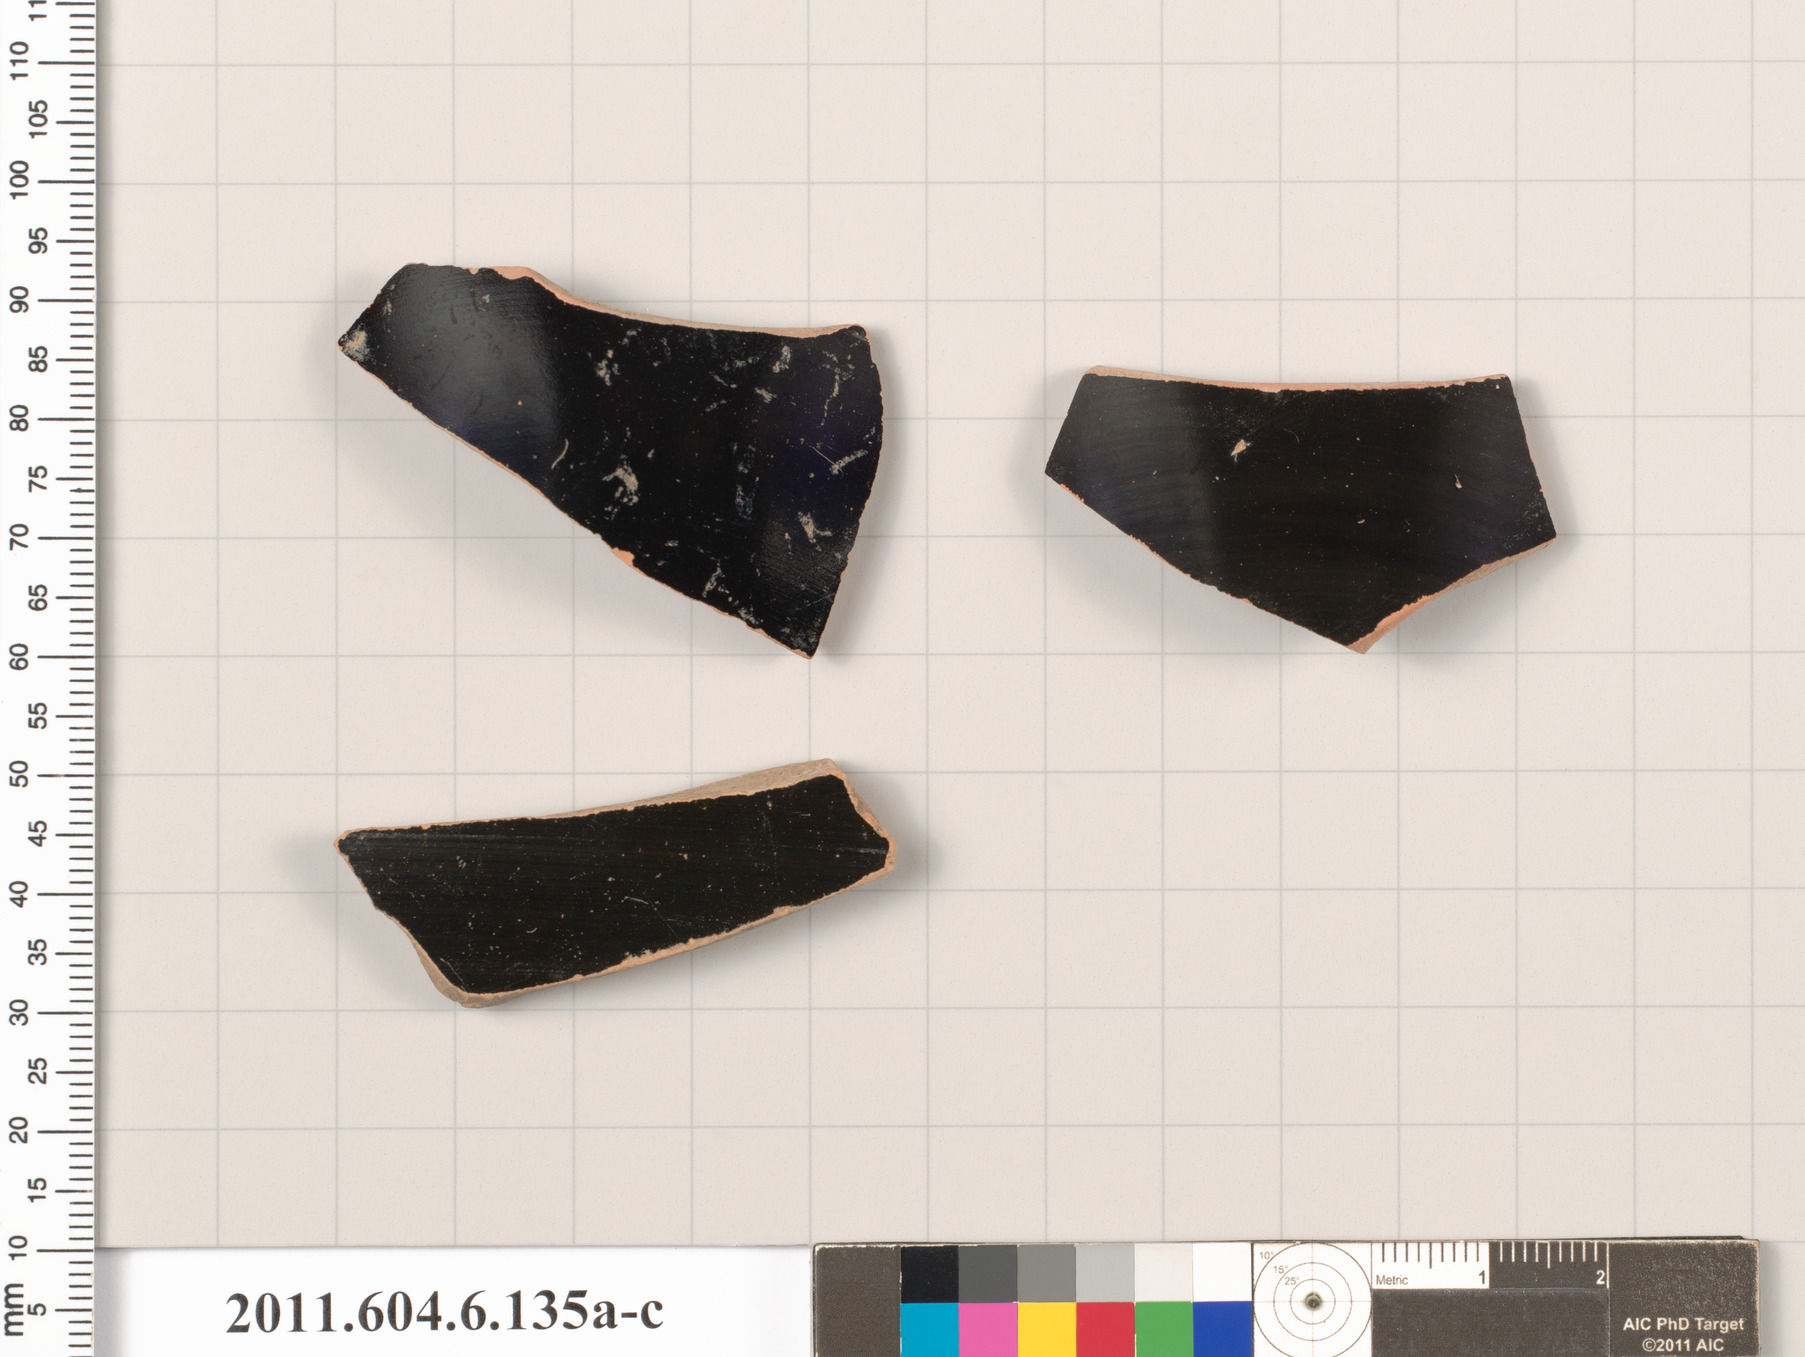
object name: undetermined open shape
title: Terracotta fragments of open shapes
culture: greek, attic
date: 600-401 BCE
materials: terracotta